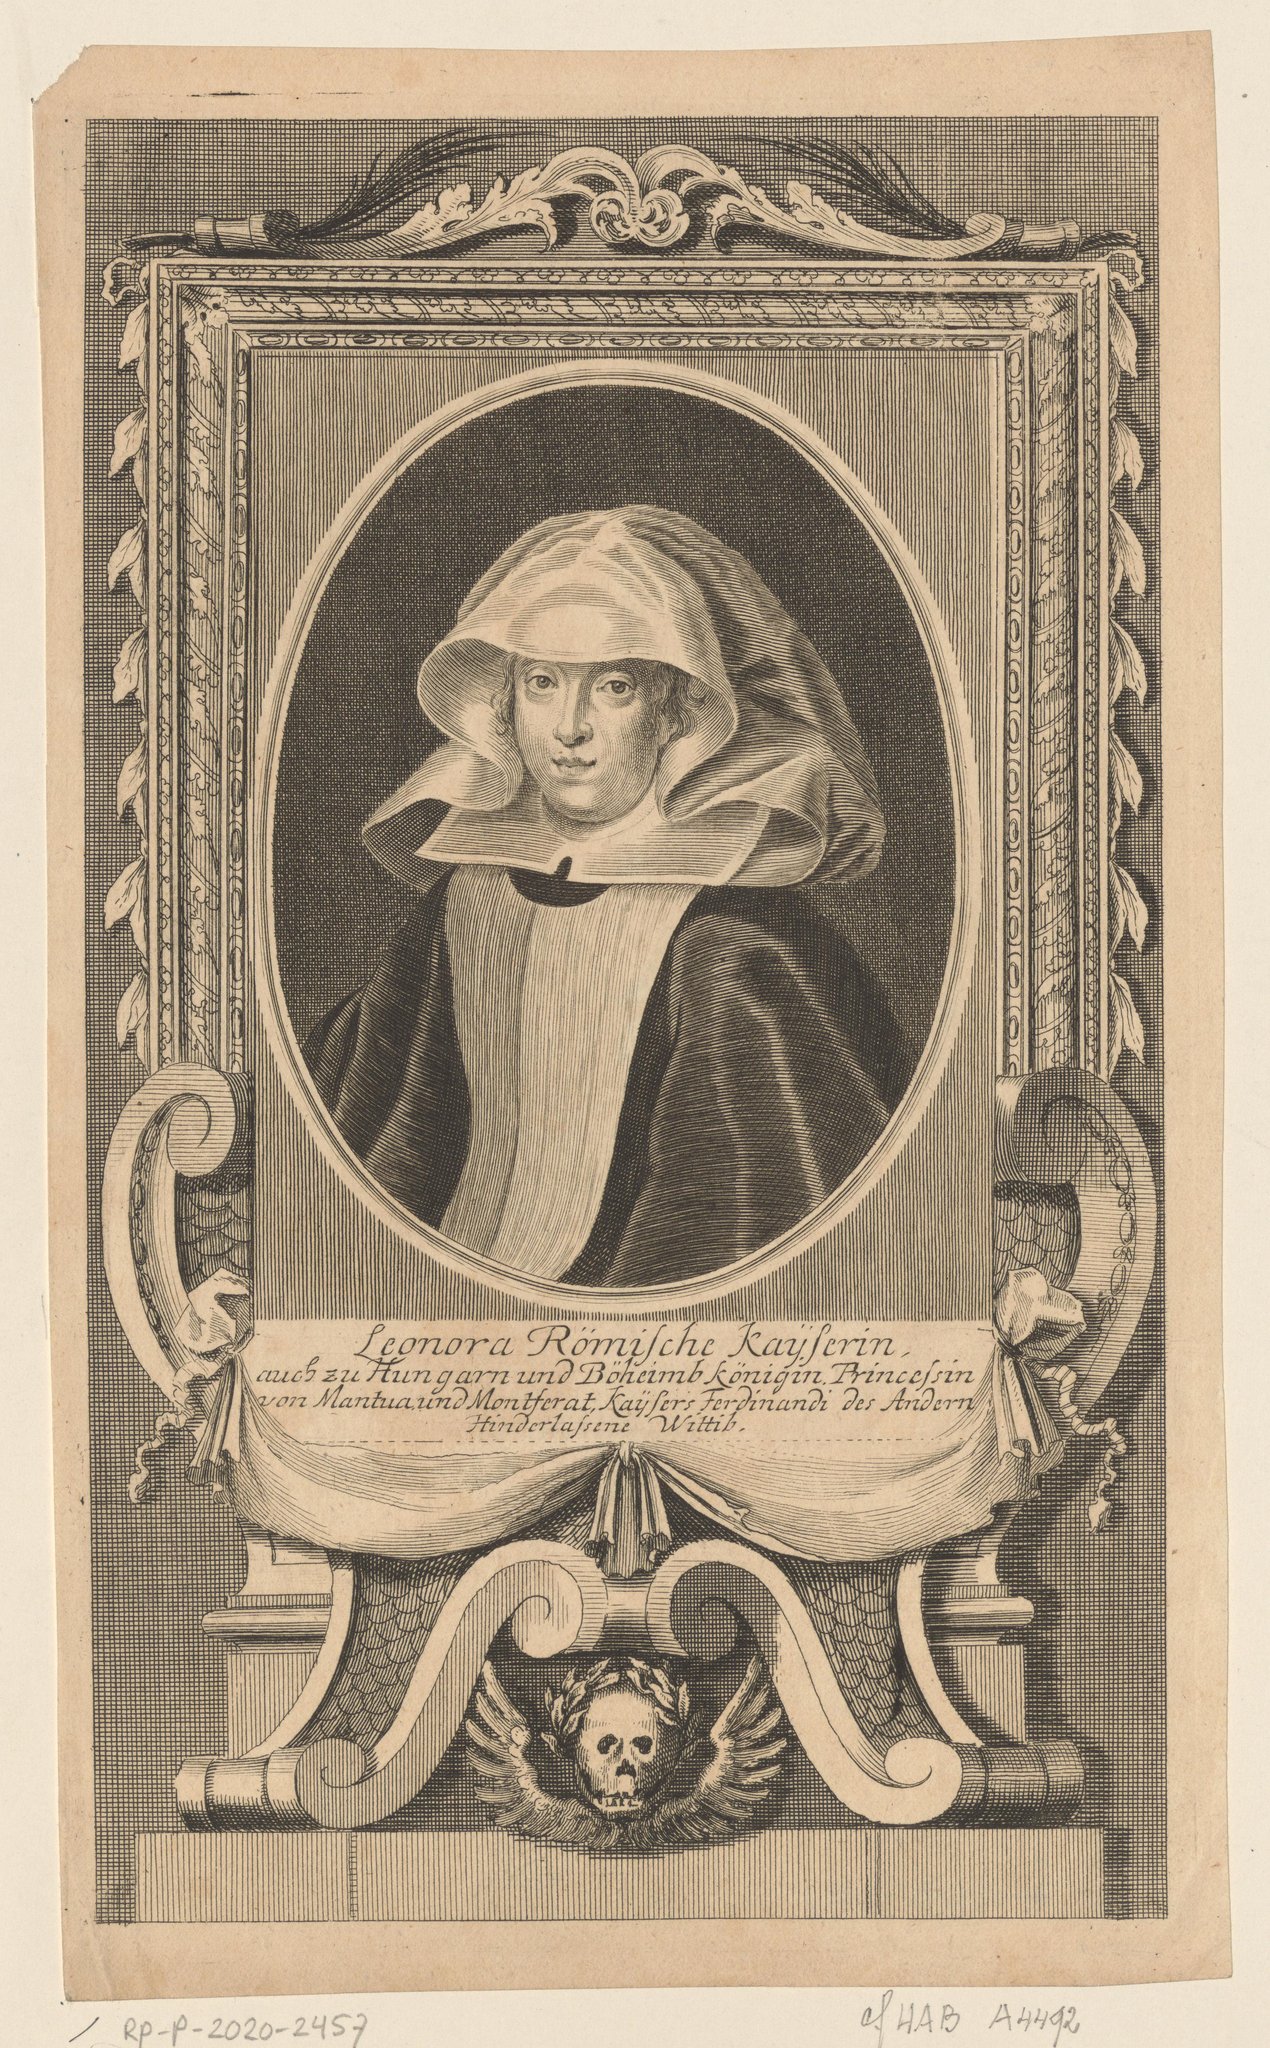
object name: book illustration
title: Portret van Eleonora Gonzaga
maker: Anonymous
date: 1721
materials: paper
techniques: engraving, etching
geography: germany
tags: vienna, historical persons - bb - woman, widow, death's head, skull (symbol of death)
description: Prent waarschijnlijk uit: Khevenhüller, Franz Christoph. Conterfet Kupfferstich (...). Leipzig: Moritz Georg Weidmann, 1721.